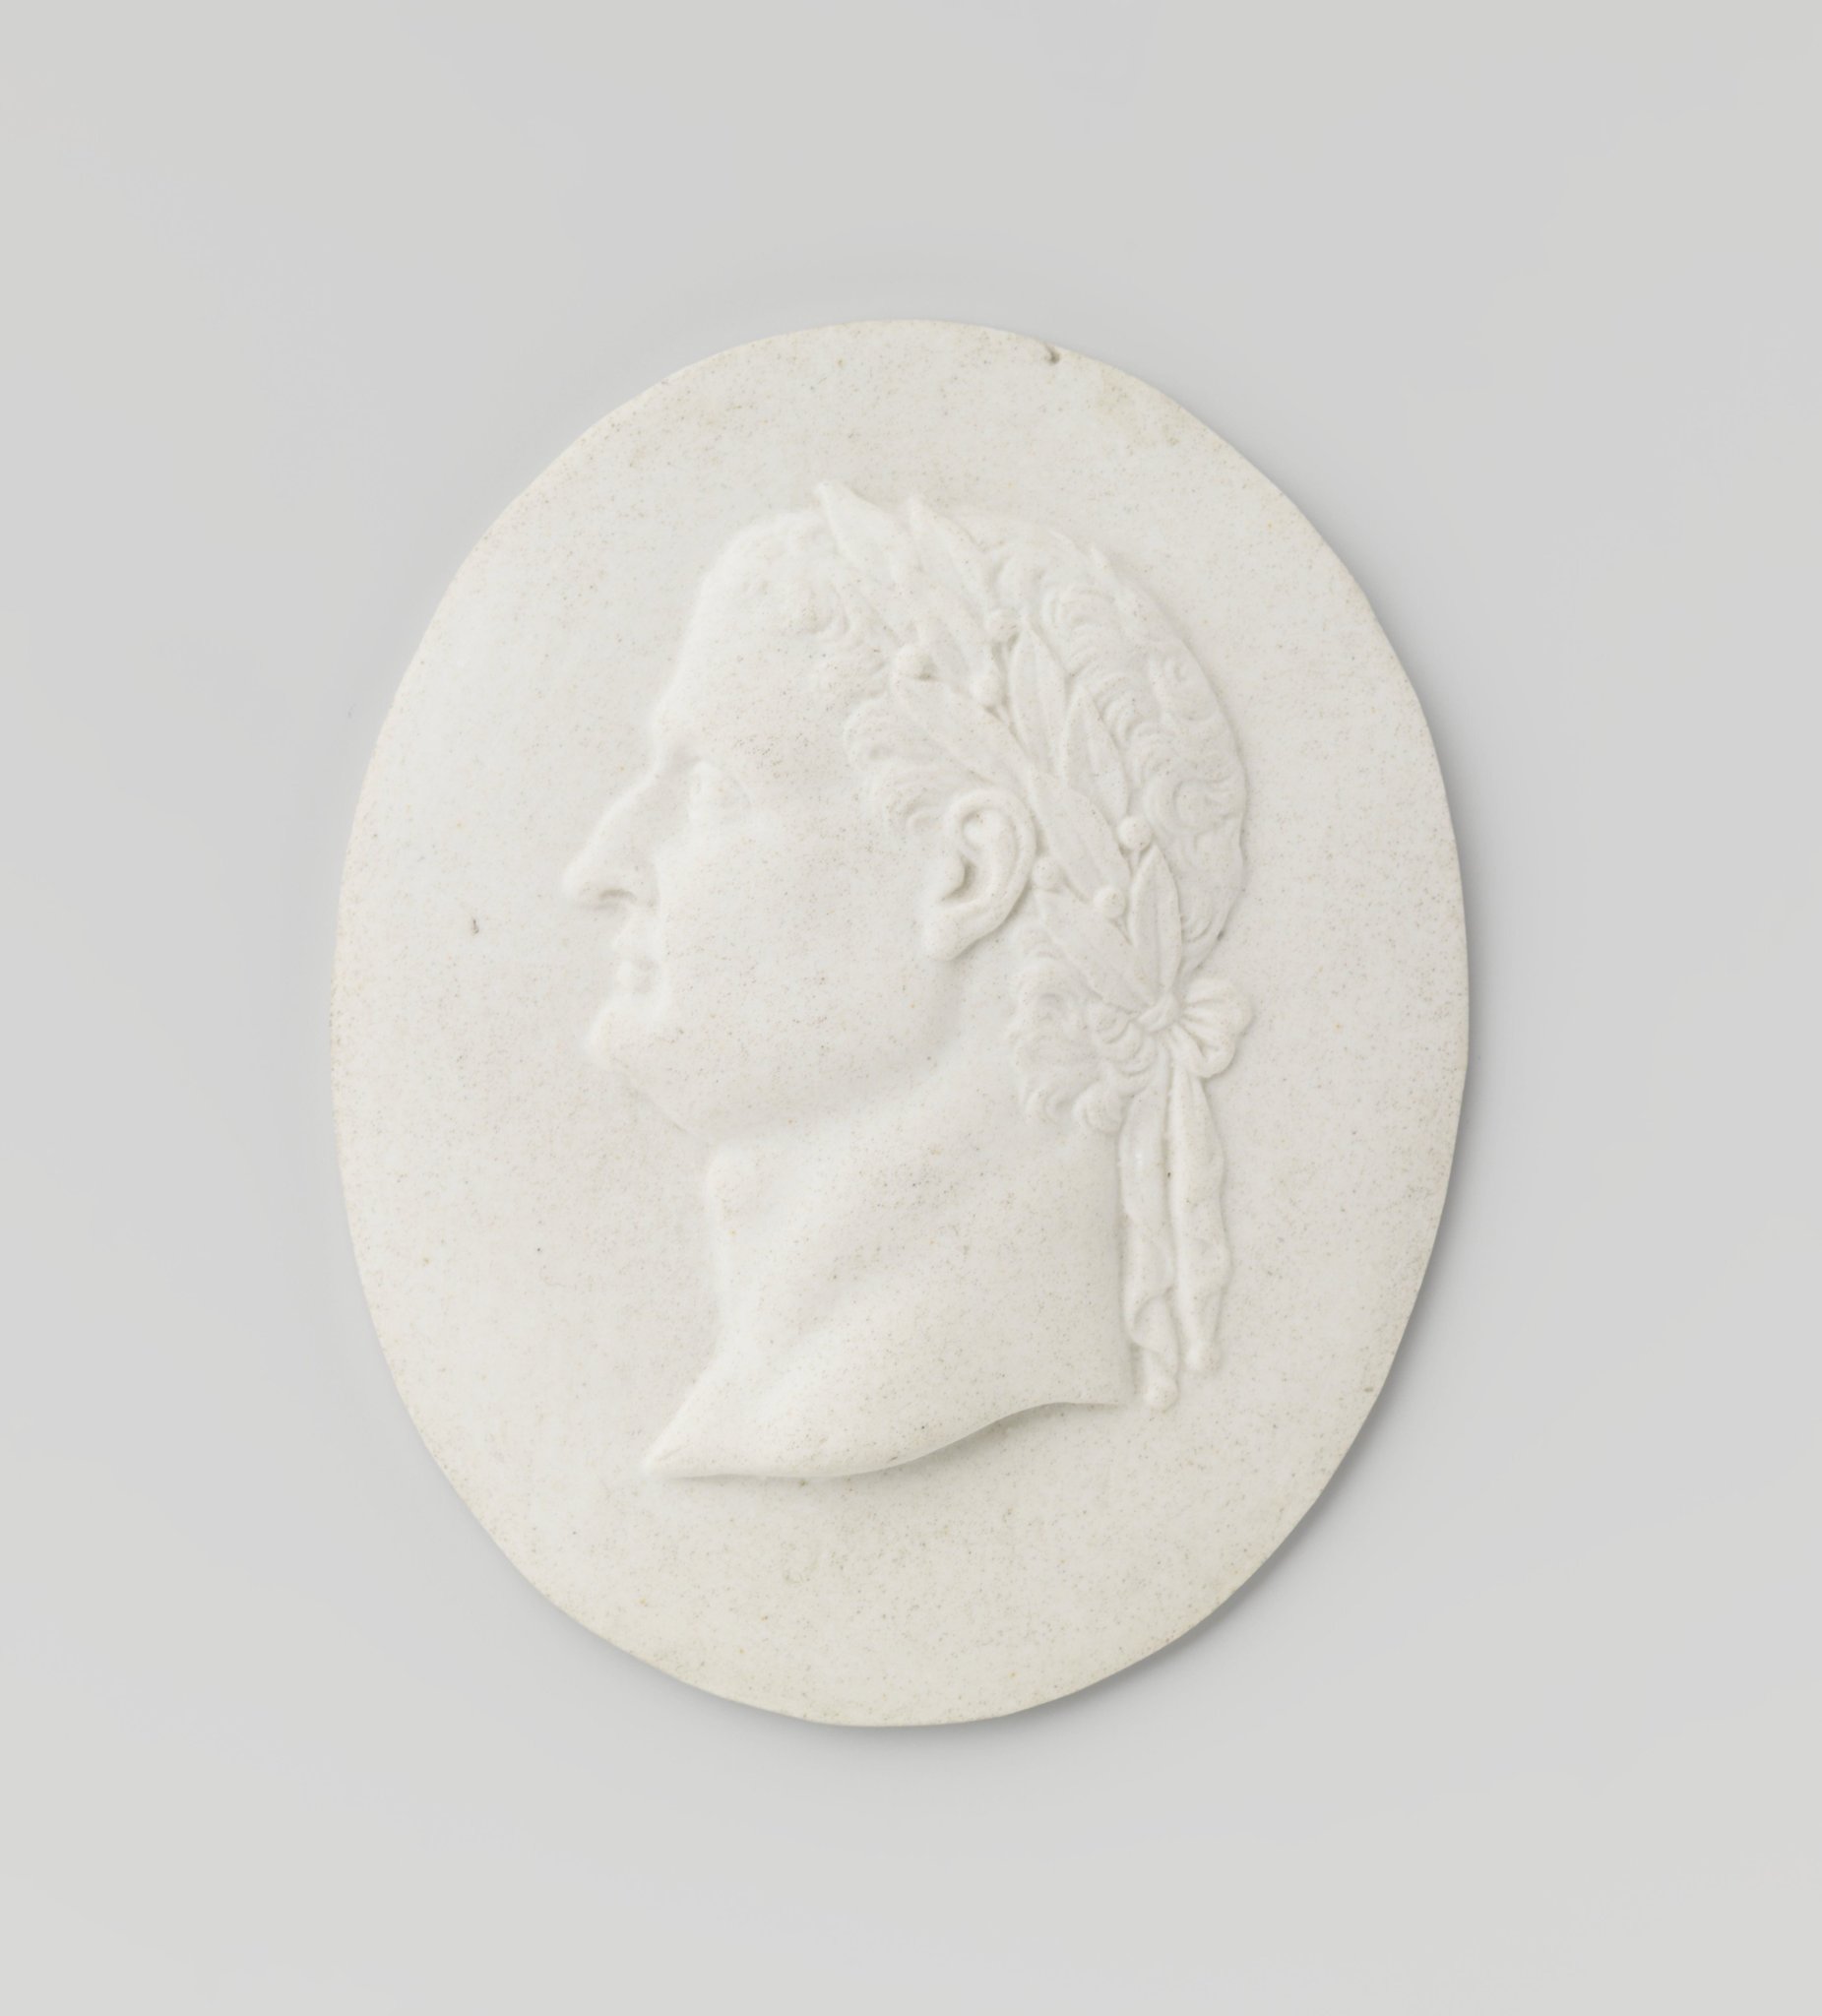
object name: portretmedaillon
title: Keizer Titus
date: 1782-1784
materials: porcelain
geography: loosdrecht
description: Five portrait medallions of the Roman Emperors Augustus, Claudius, Vespasian, Titus and Domitian. Biscuit porcelain. Loosdrecht, c. 1778 - 1782. Factory of Joannes de Mol.